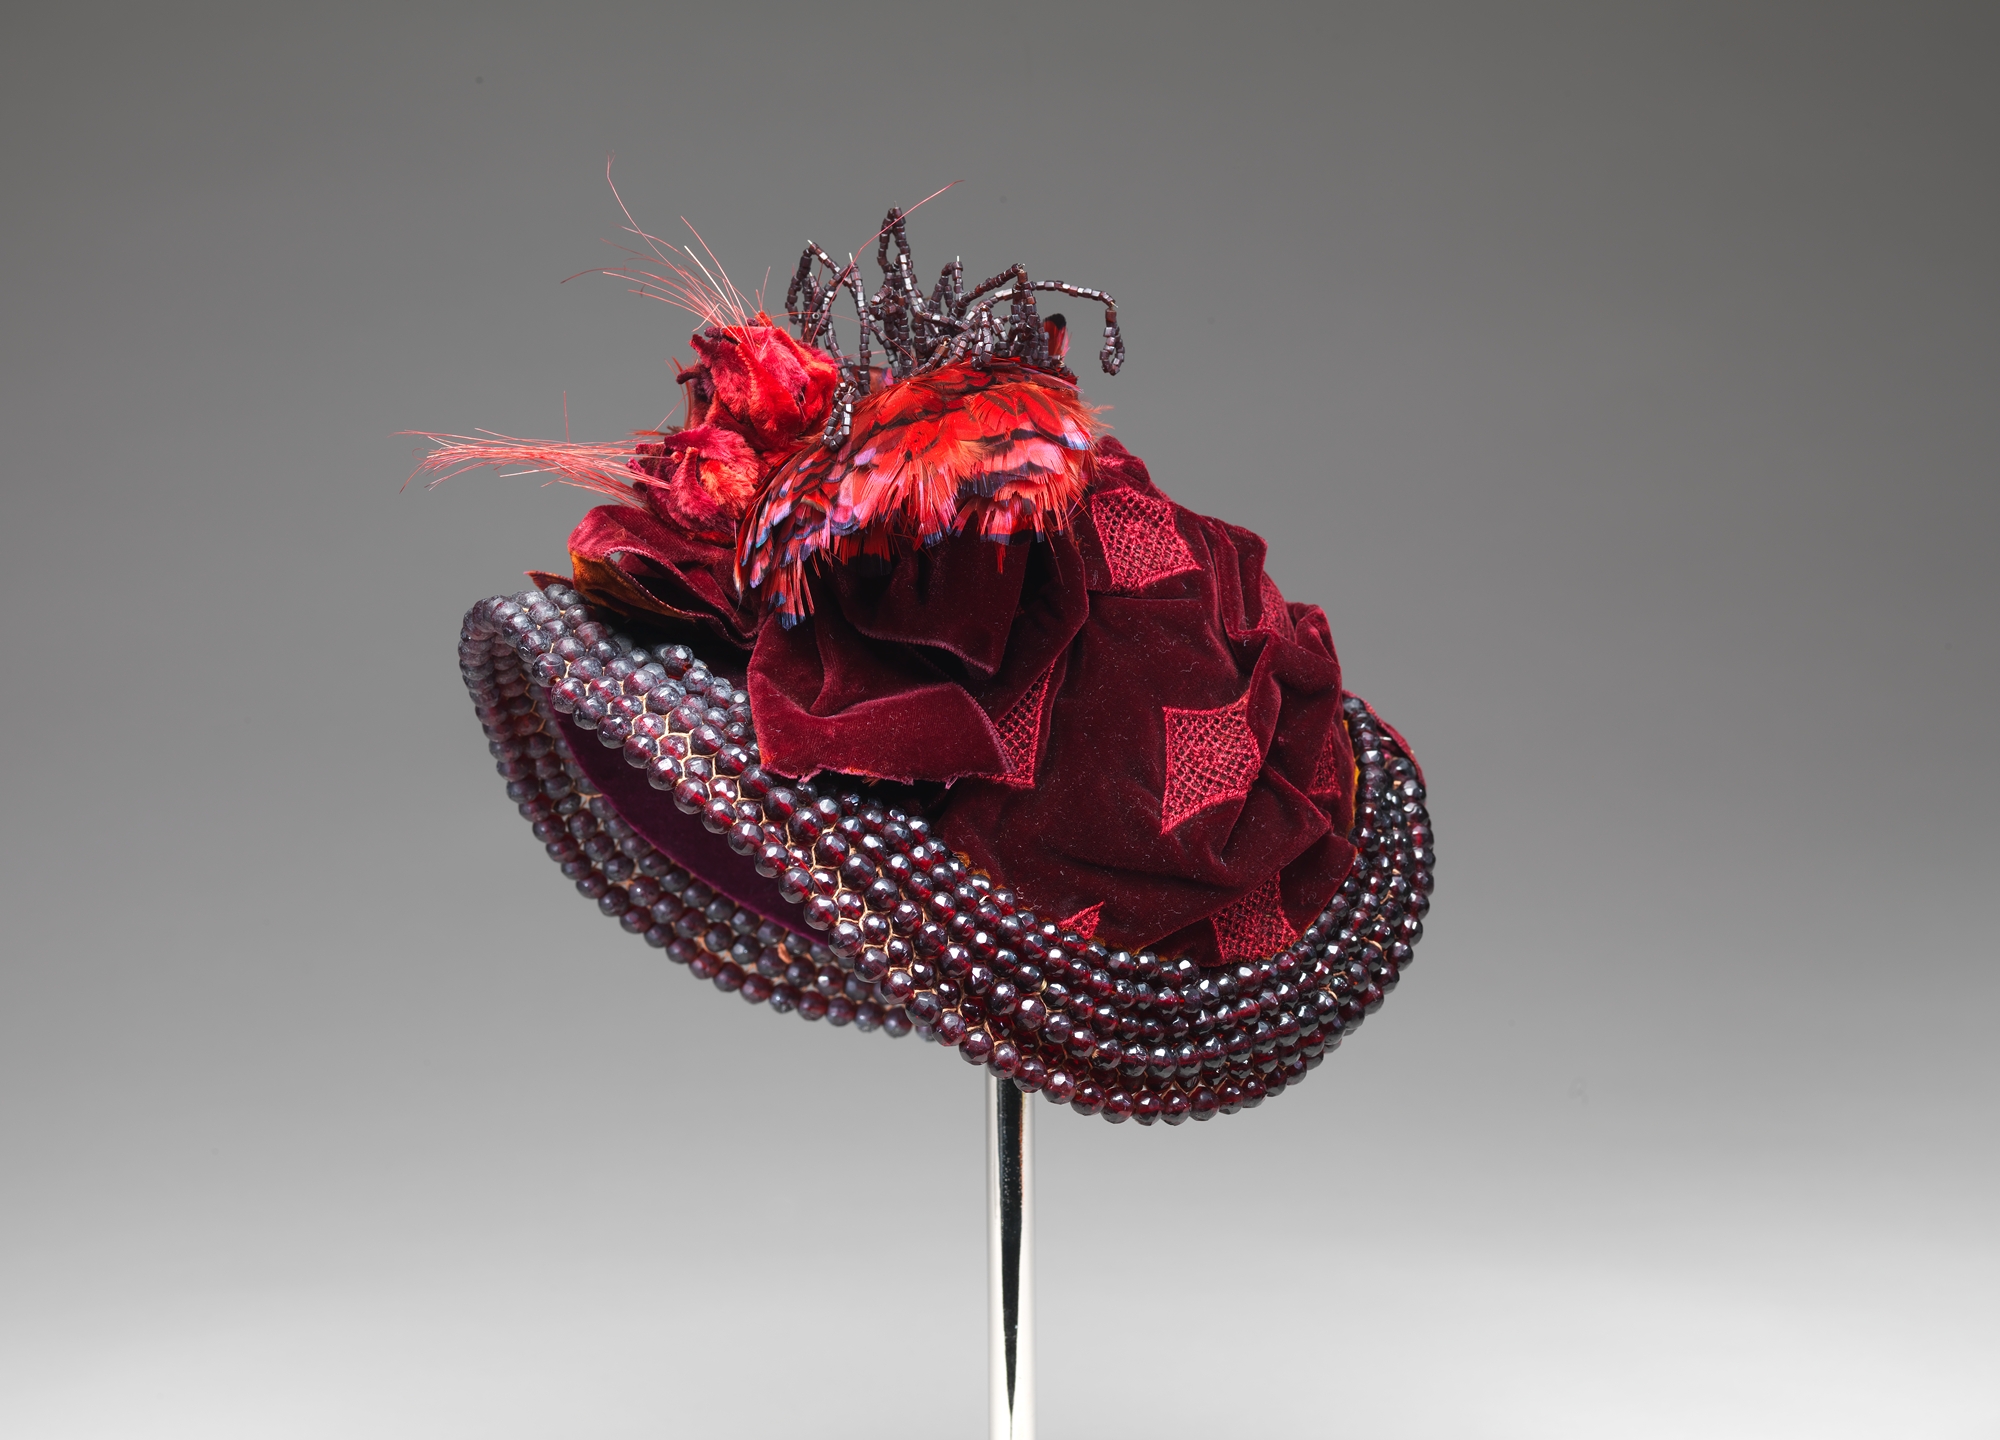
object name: bonnet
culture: french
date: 1883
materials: feather, silk, metal